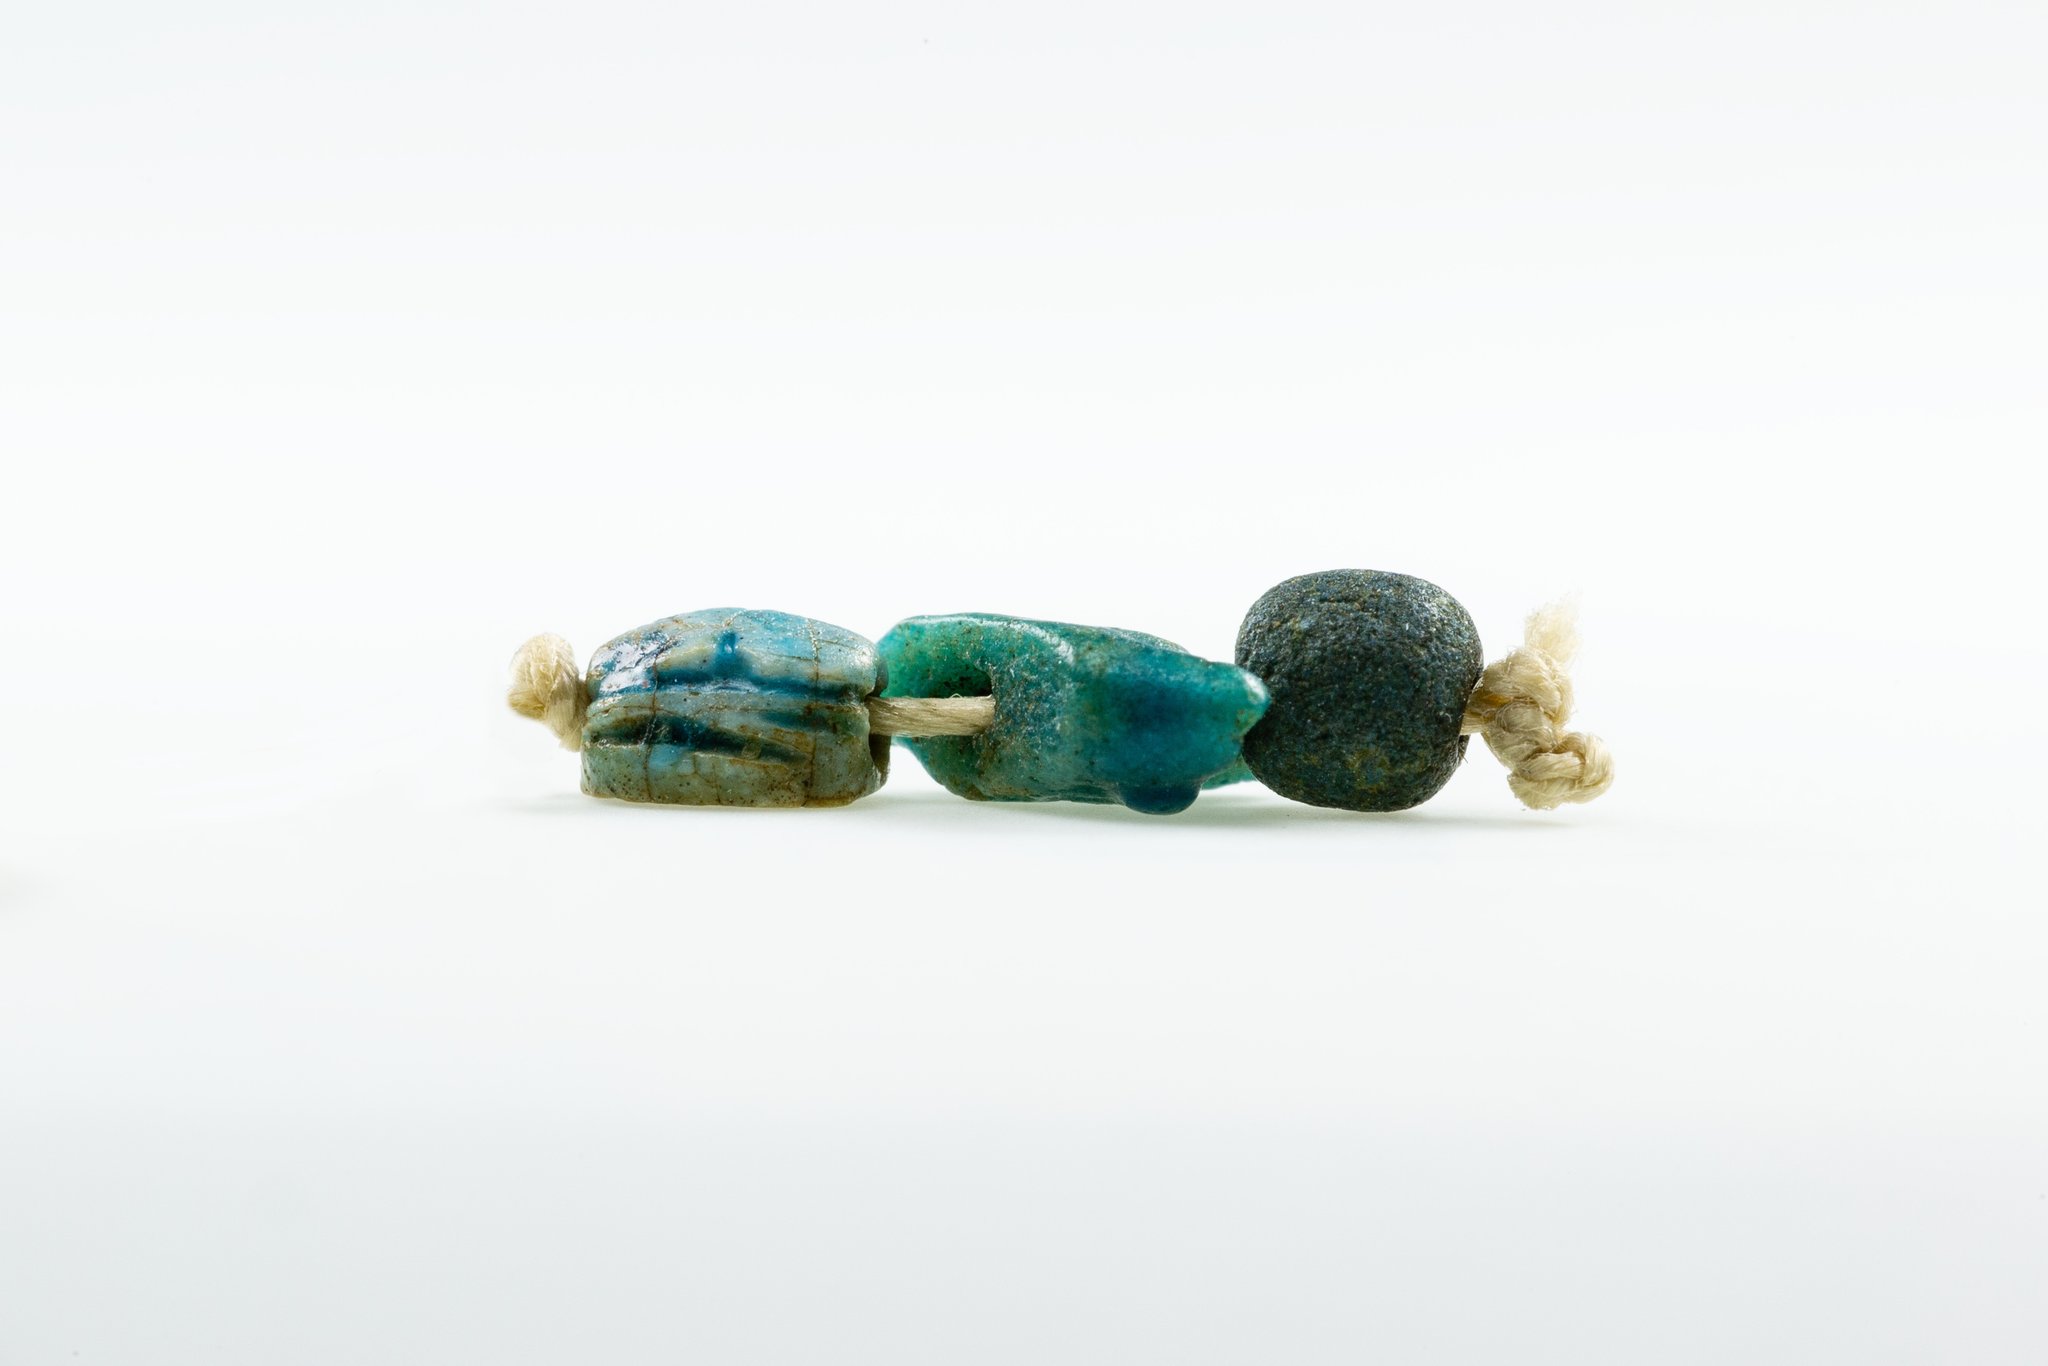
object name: amulet, falcon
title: Falcon amulet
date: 1981-1640 BCE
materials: faience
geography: egypt